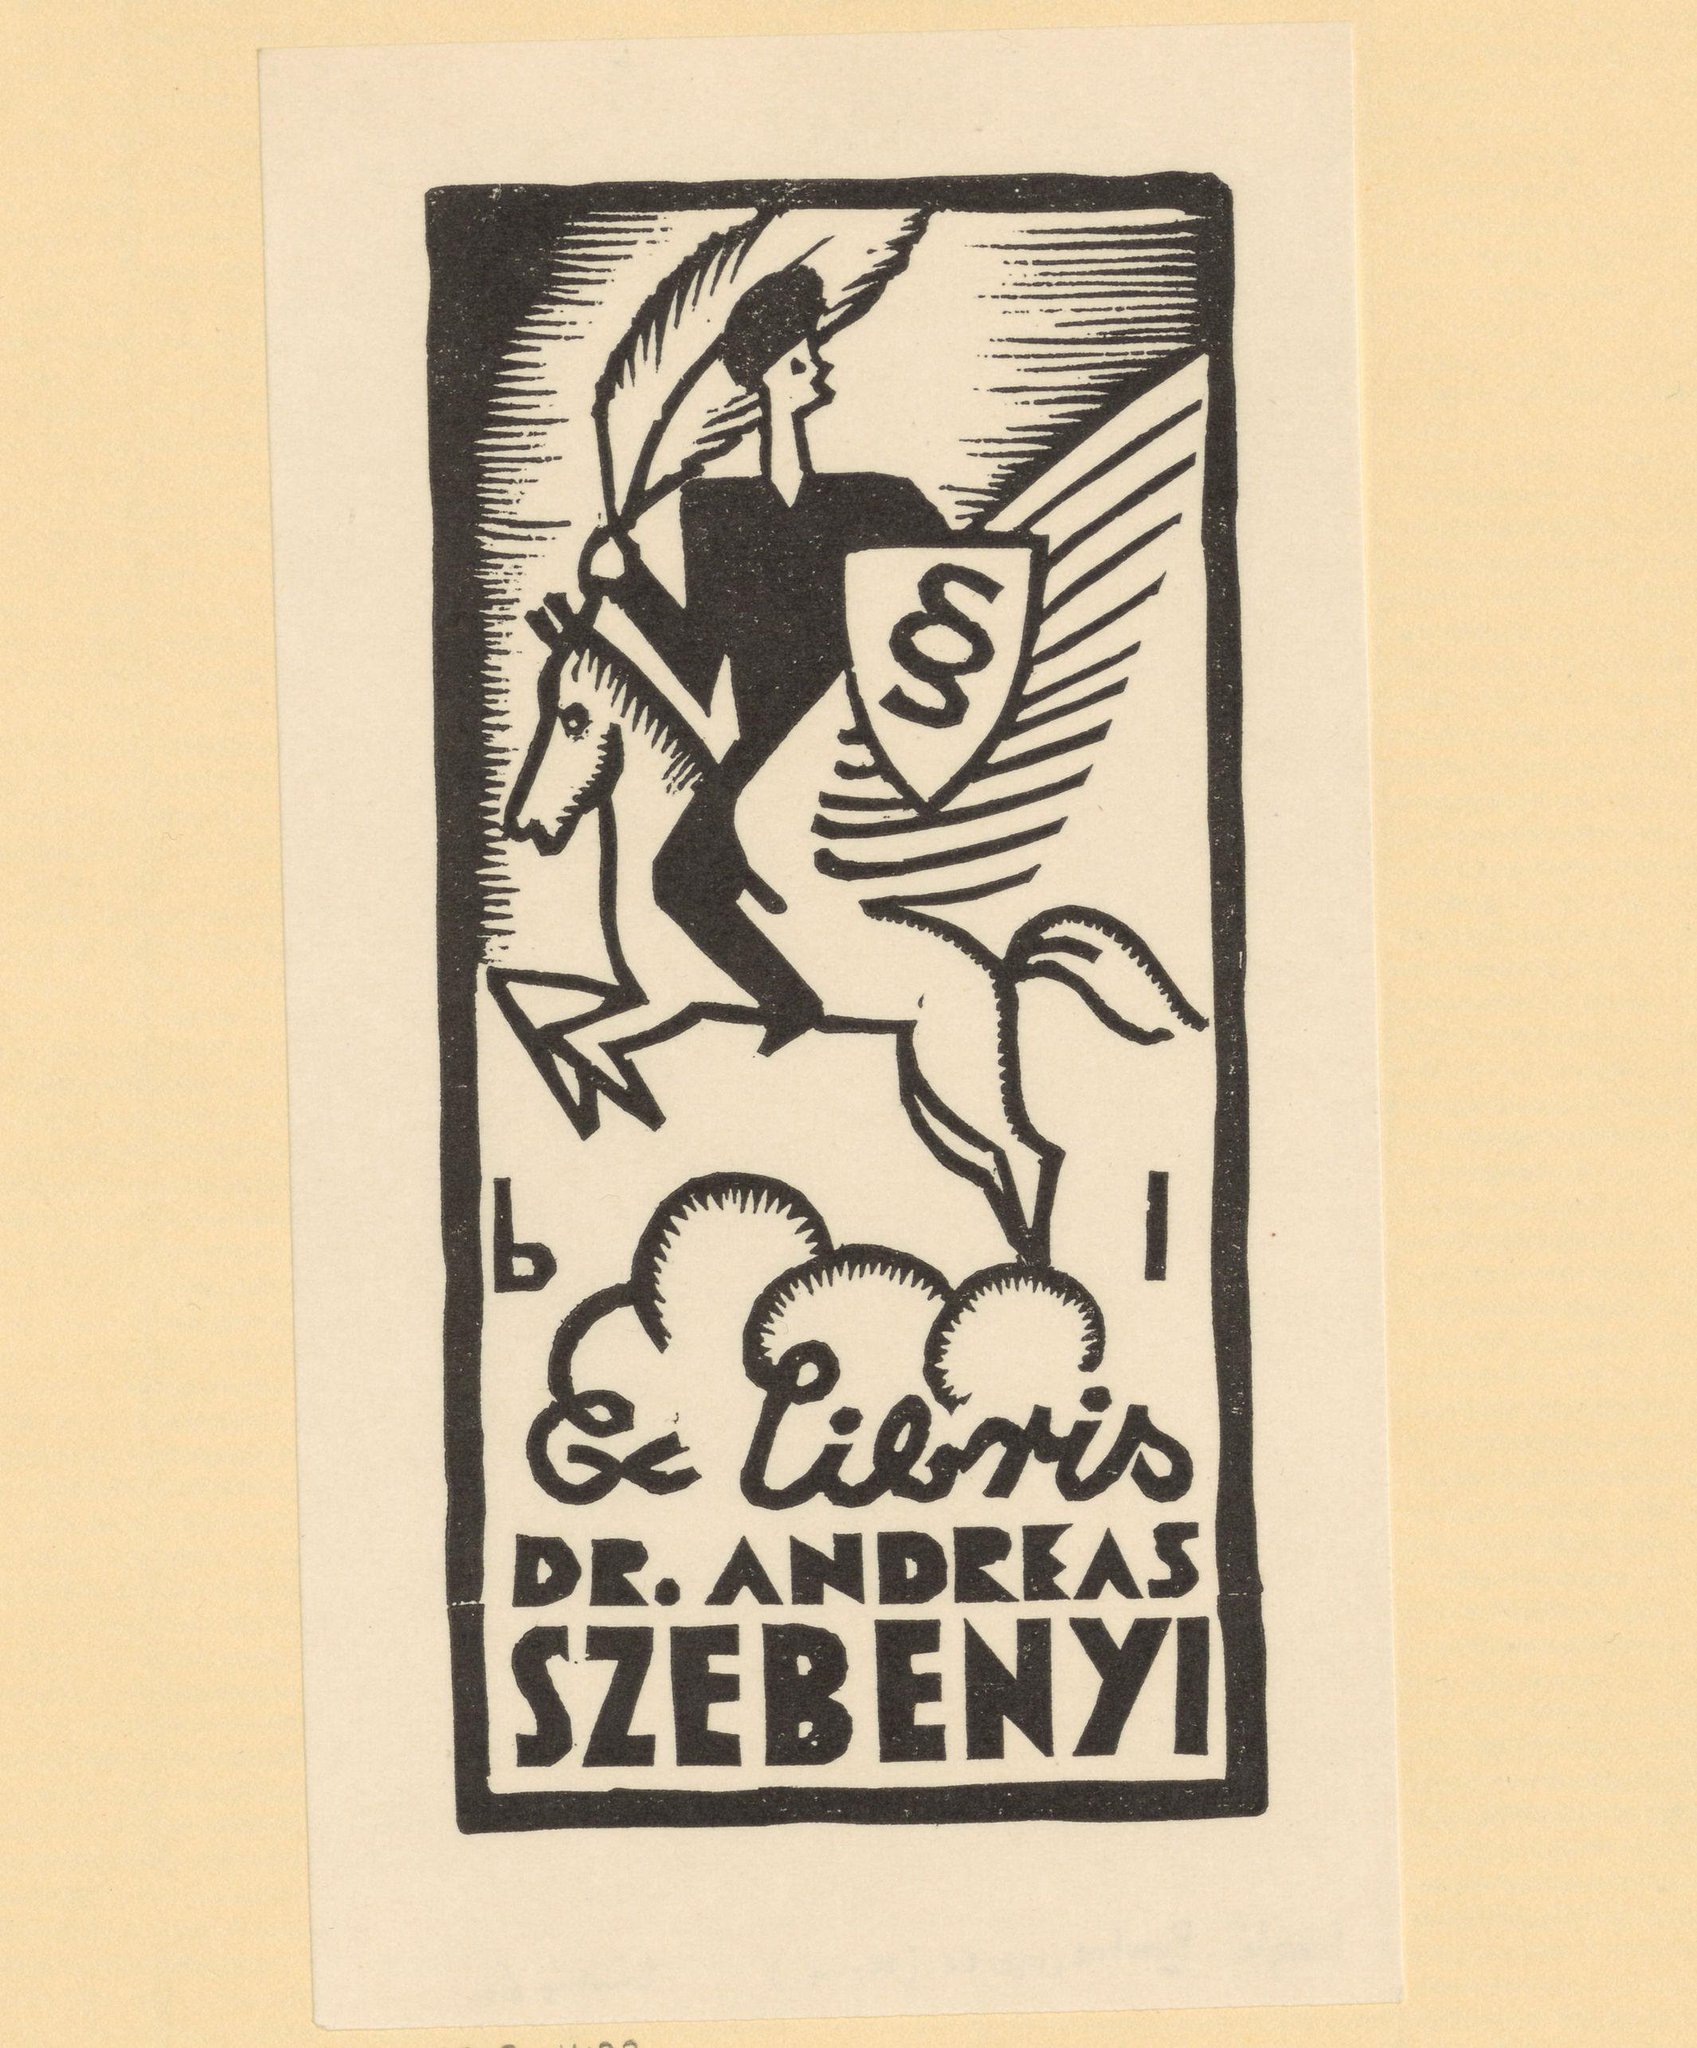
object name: bookplate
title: Ex libris van Andreas Szebenyi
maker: lászló bartos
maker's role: print maker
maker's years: 1902-1943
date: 1912-1943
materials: paper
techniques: linocut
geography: hungary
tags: riding a horse, ass, or mule; rider, horseman, pegasus, the winged horse, quill